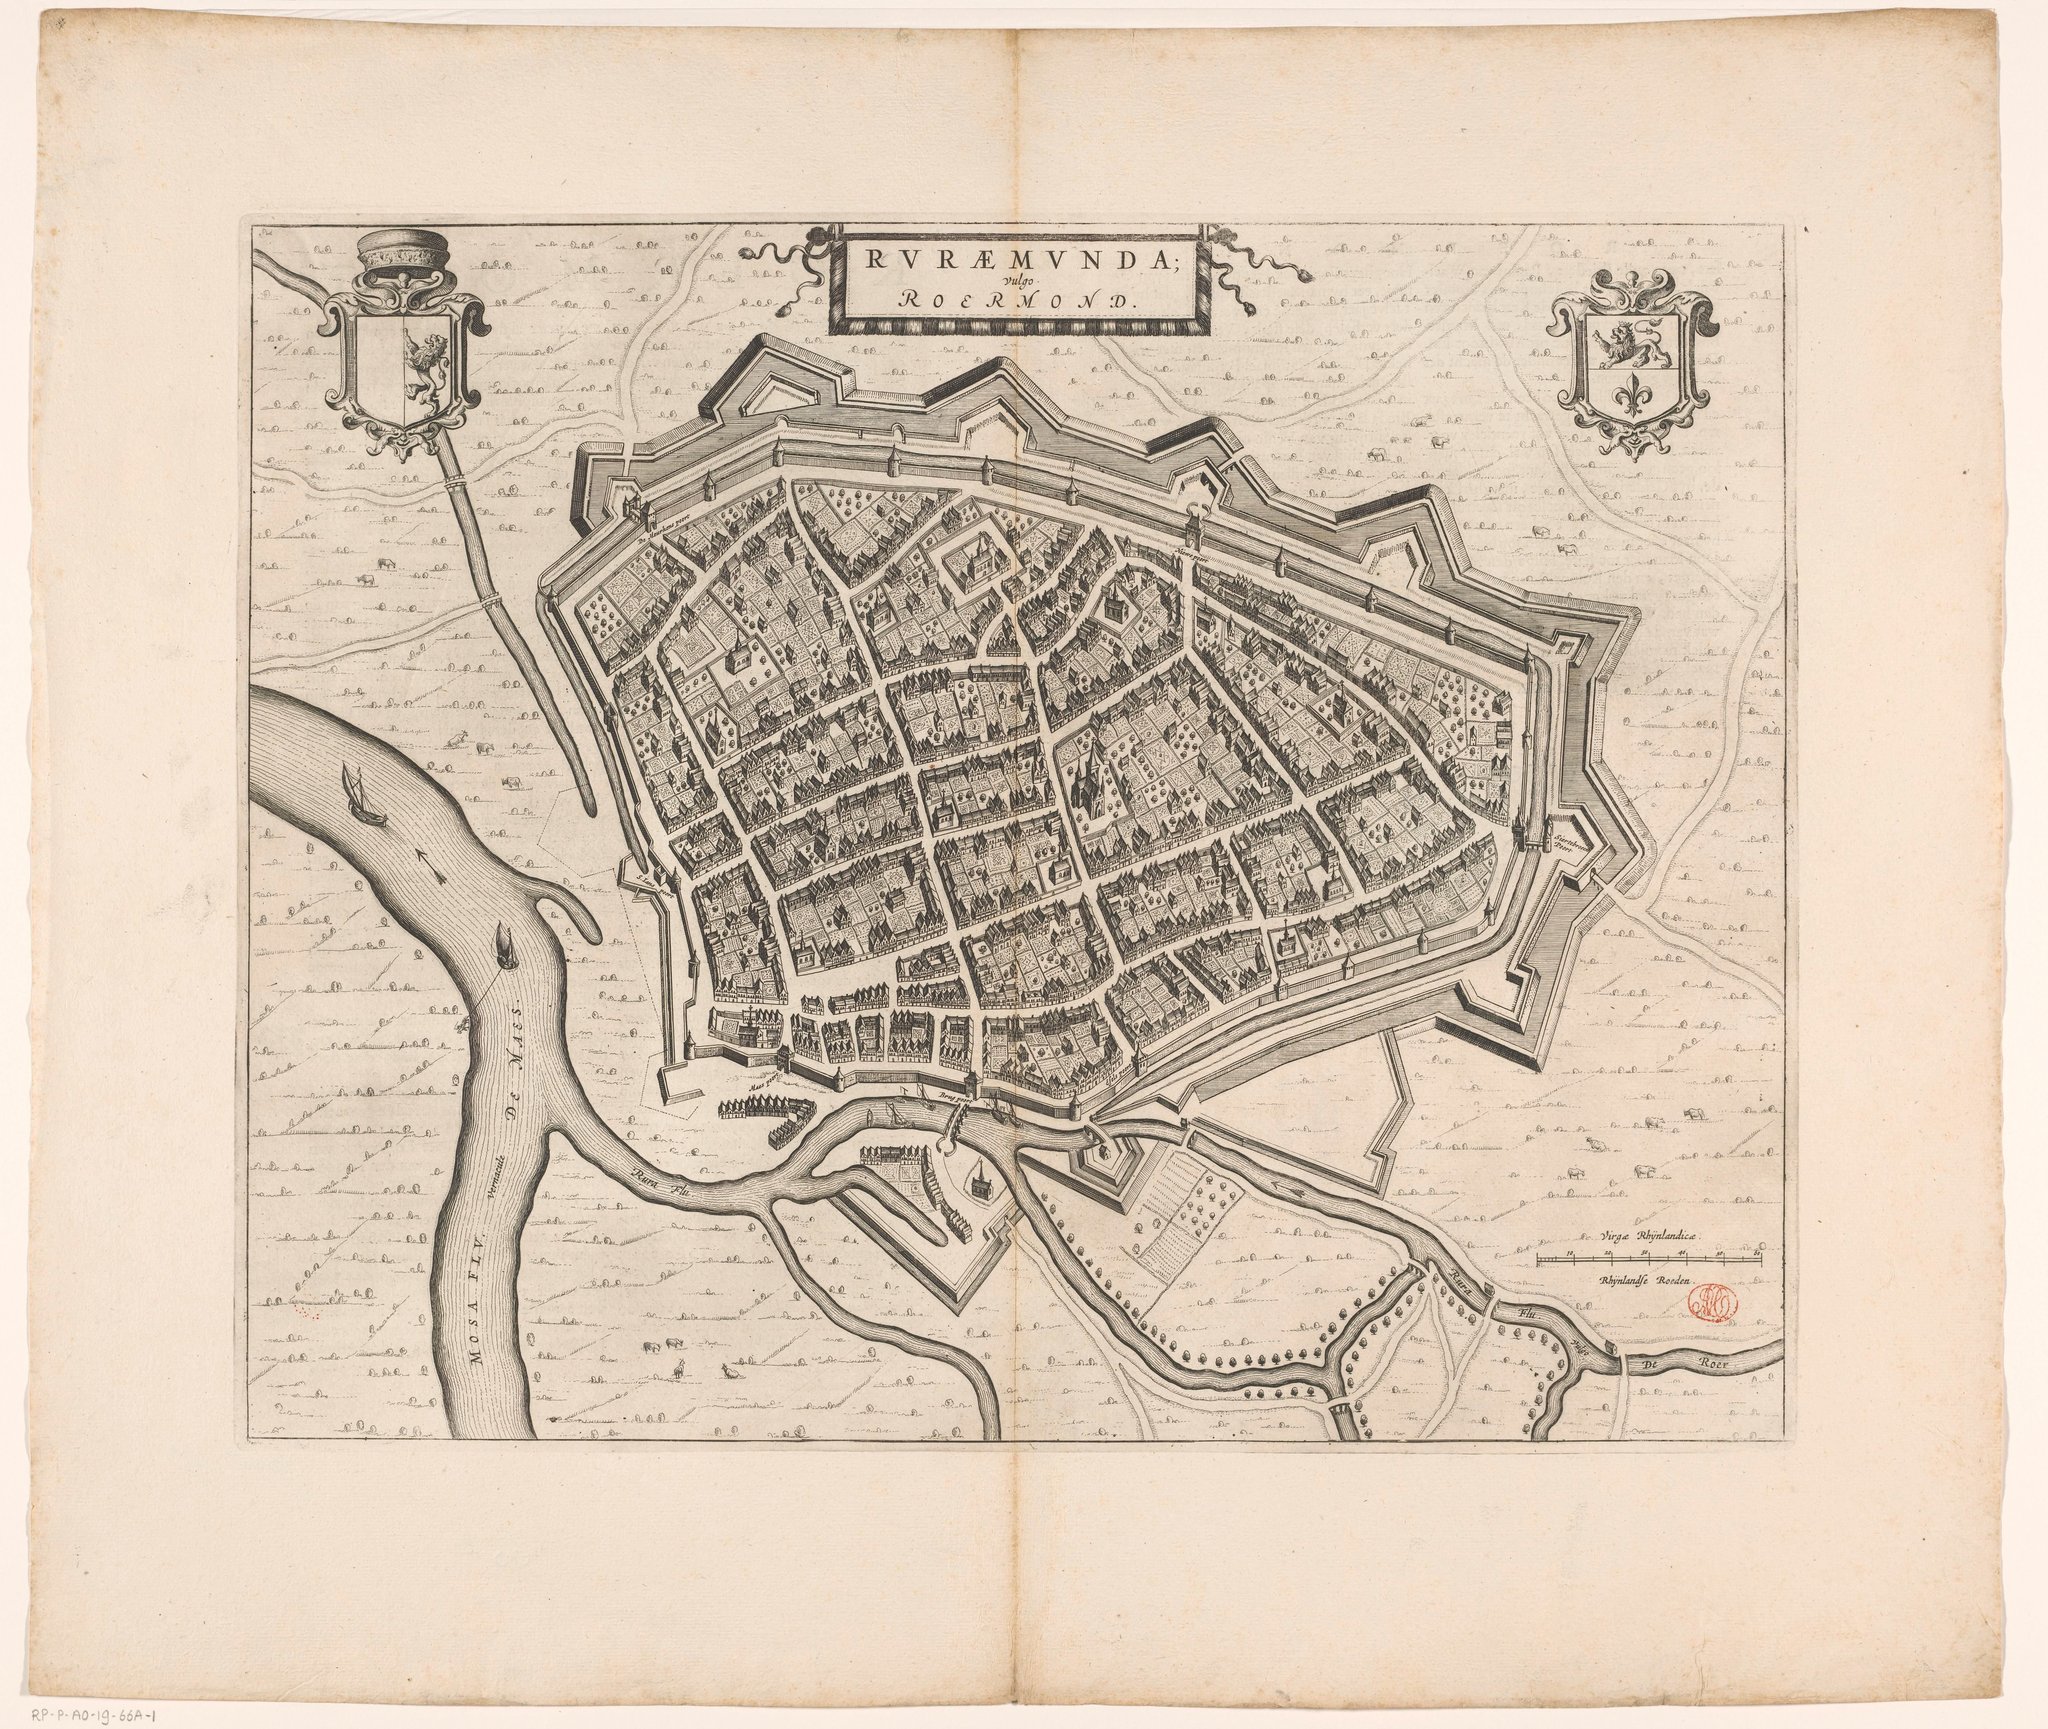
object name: area plan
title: Plattegrond van Roermond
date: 1652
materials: paper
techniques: engraving, etching, letterpress printing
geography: amsterdam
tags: coat of arms (as symbol of the state, etc.) (+ city; municipal), fortified city, maps of cities, coat of arms (as symbol of the state, etc.) (+ province; provincial)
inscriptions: collector's mark: Lugt 2228, collector's mark: Lugt 195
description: Plattegrond van Roermond met gebouwen in vogelvluchtperspectief. Boven, in het midden, de titelcartouche. Rechtsonder een schaalstok: 60 Rhijnlandse Roeden. Linksboven de helft van het wapen van het hertogdom Gelre, rechtsboven het wapen van Roermond. Met Nederlandse tekst op verso.